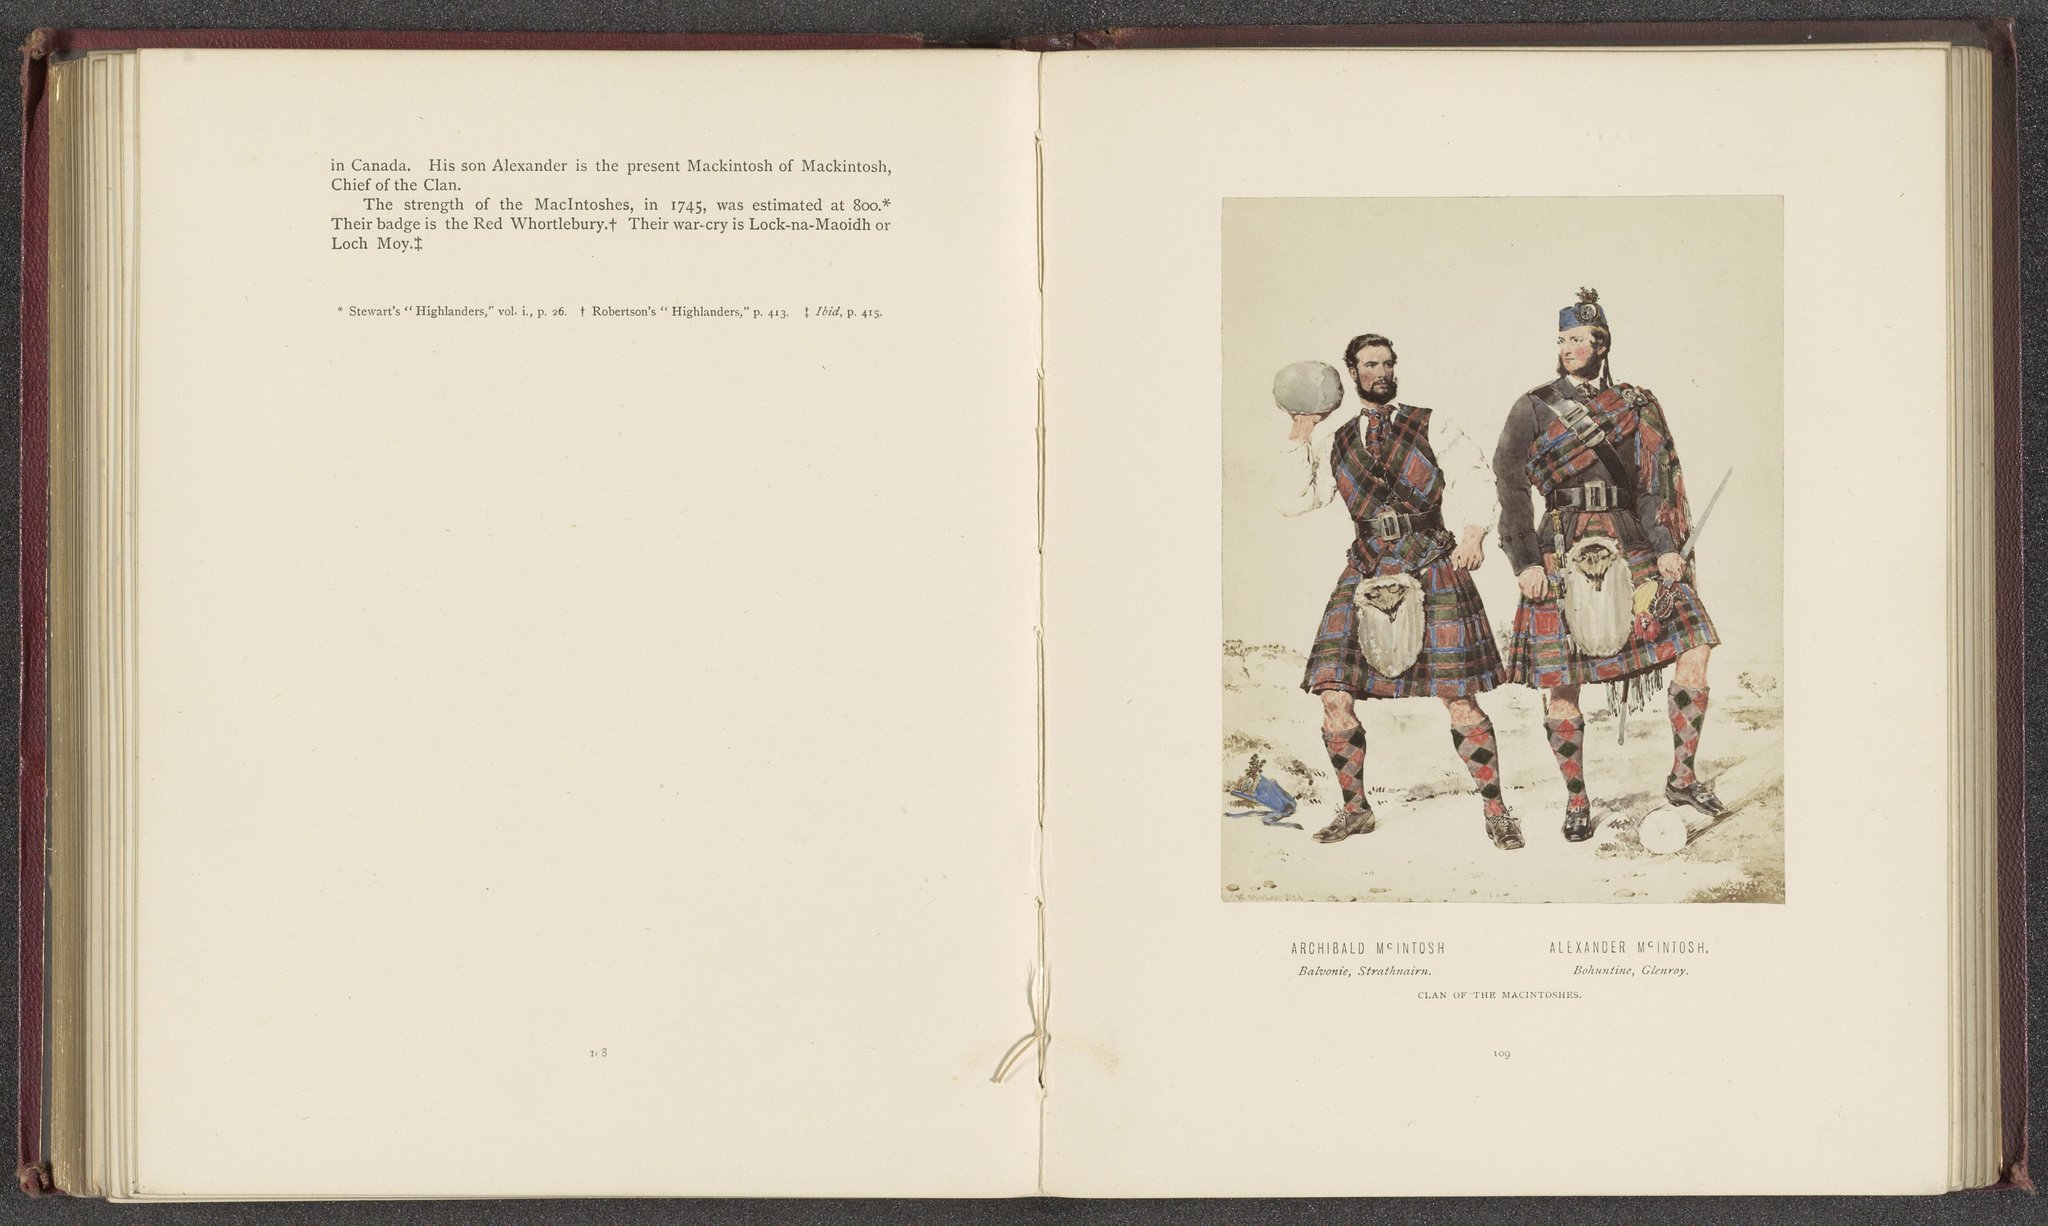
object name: page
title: Fotoreproductie van een tekening van portretten van Archibald en Alexander Mackintosch van de Clan Mackintosh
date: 1860-1870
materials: photographic support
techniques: albumen print, hand coloring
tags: adult man, folk costume, regional costume